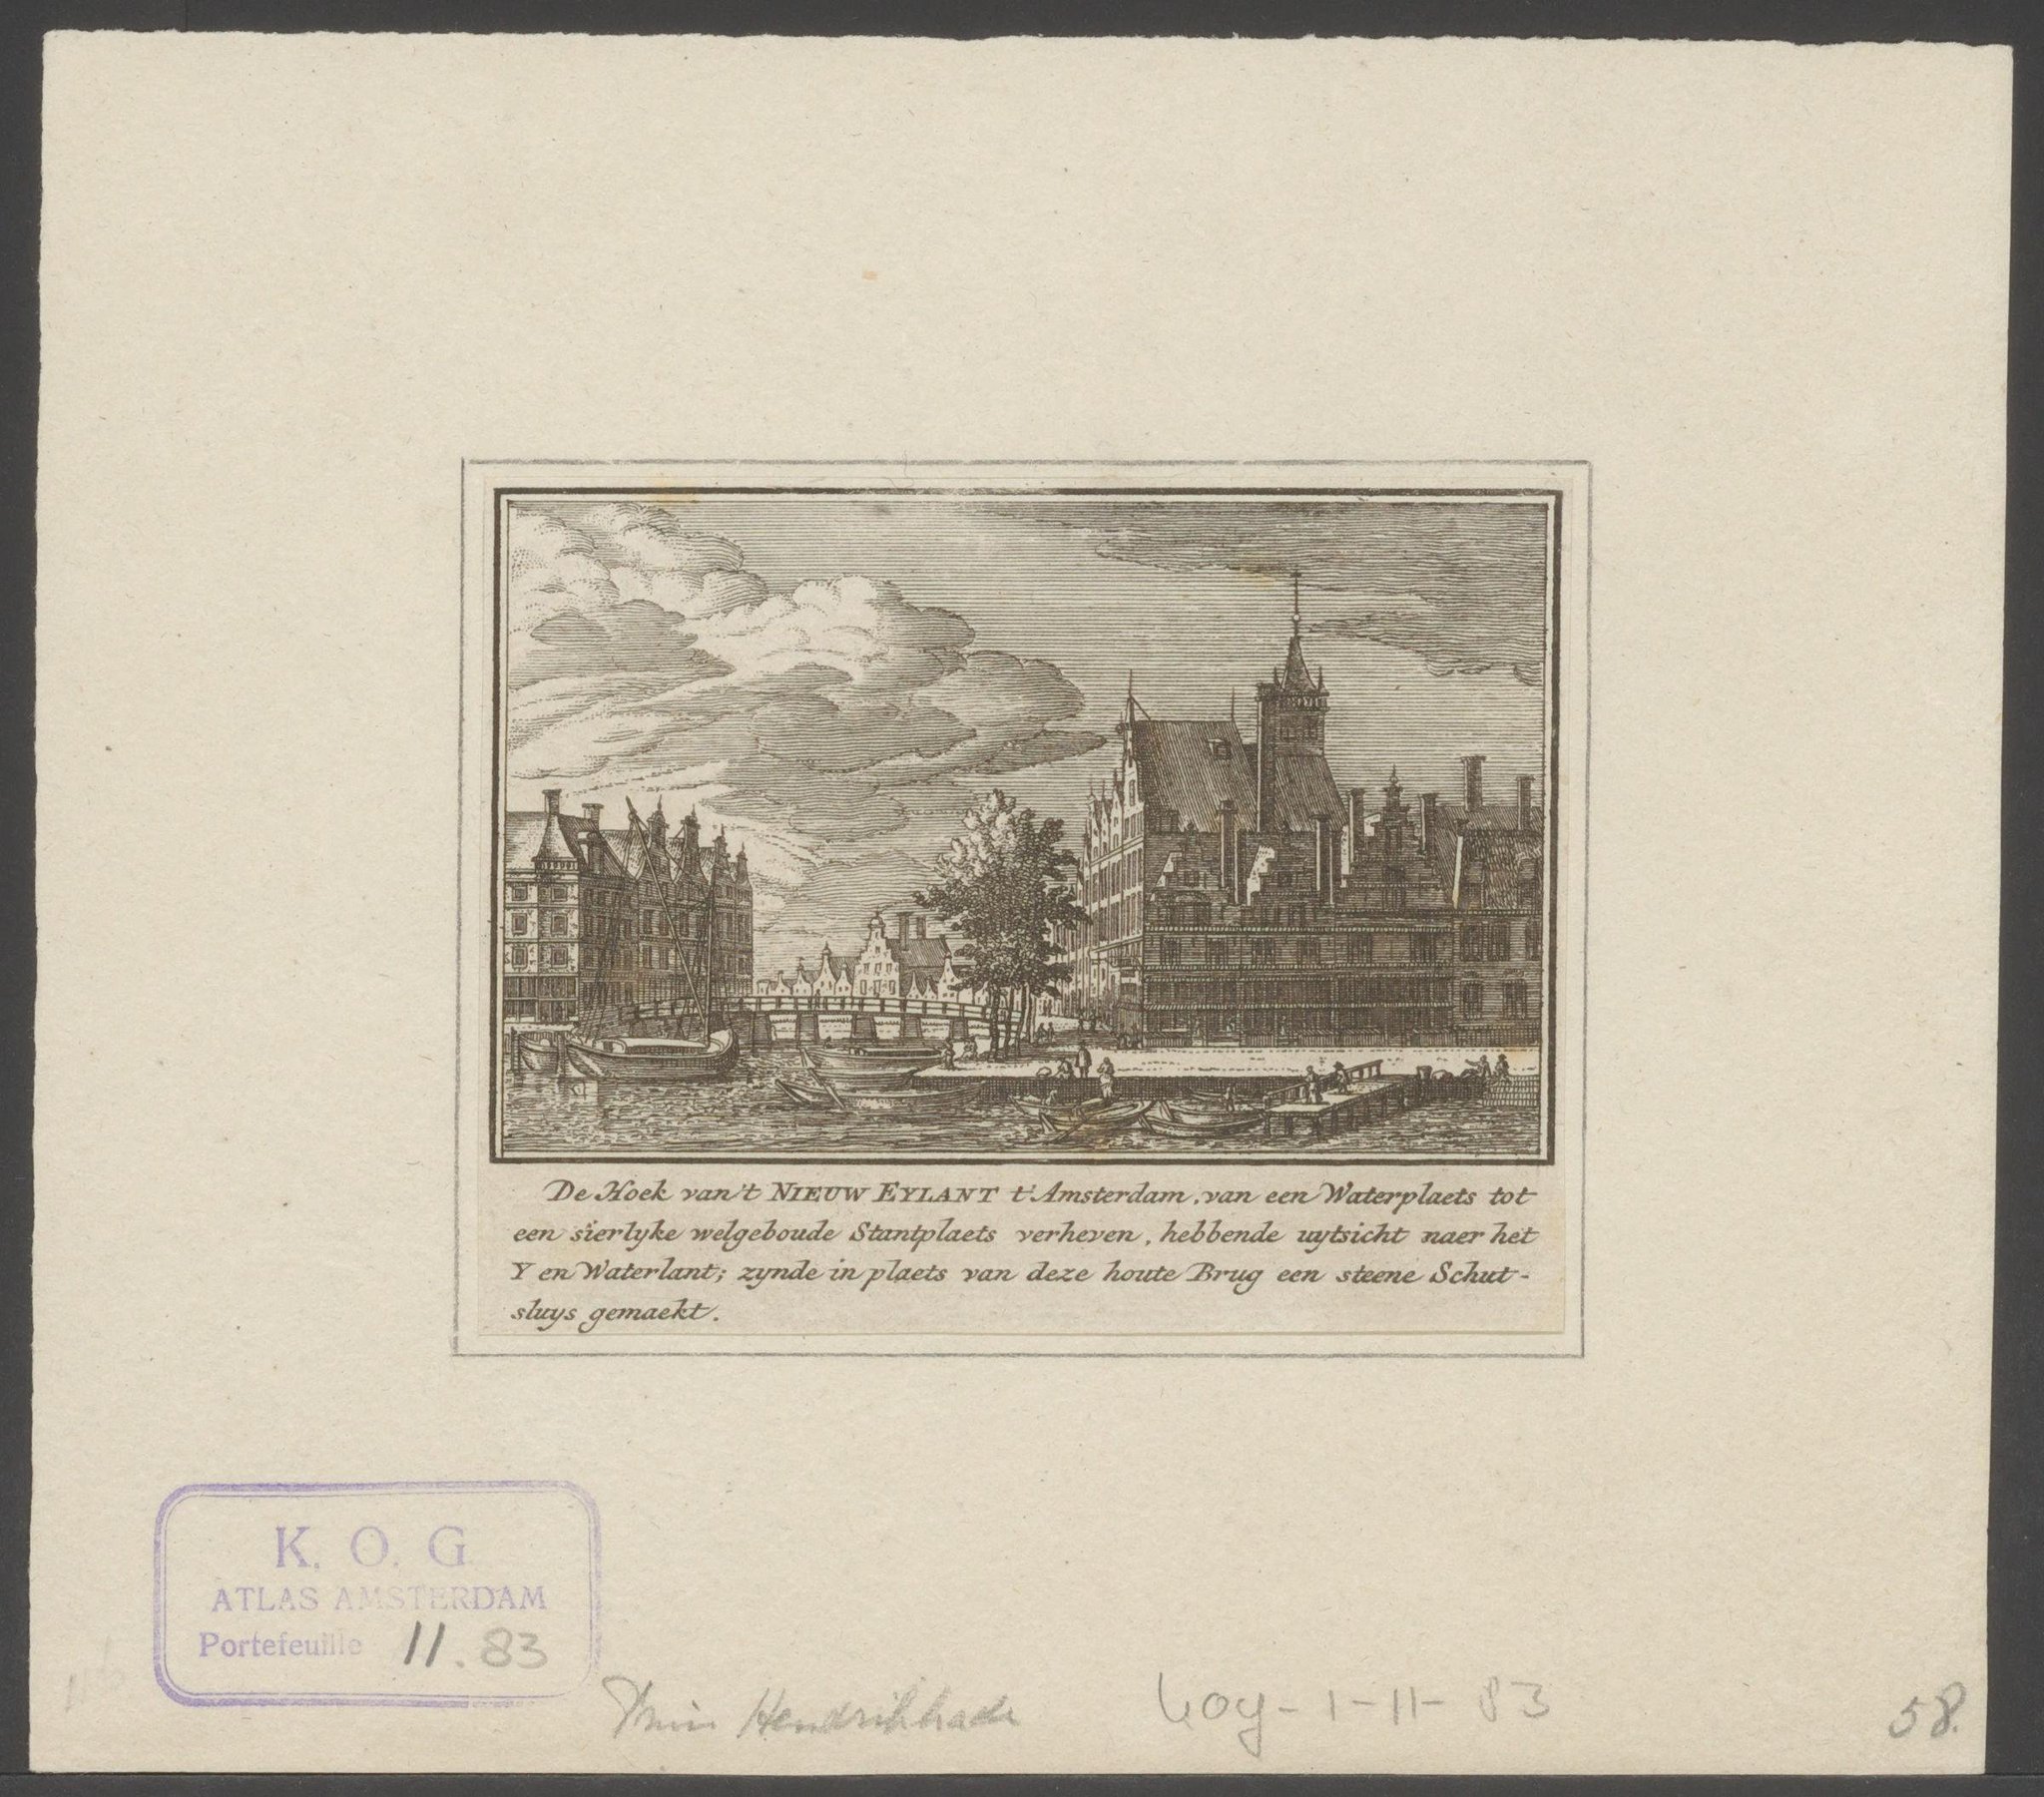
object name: print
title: Gezicht op het Waalseiland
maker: Anonymous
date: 1725-1750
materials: paper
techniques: etching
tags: city-view in general; 'veduta', canal, the usual house or row of houses, bridge in city across river, canal, etc.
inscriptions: collector's mark: ‘11.83’ Lugt 1641b, inscription: ‘Prins Hendrikkade’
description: Onderwerpsrubriek binnen de Atlas Amsterdam: Prinsengracht, Korte Prinsengracht, Prins Hendrikkade. Zie ook Portefeuille 1: gezichten van het IJ op de stad.